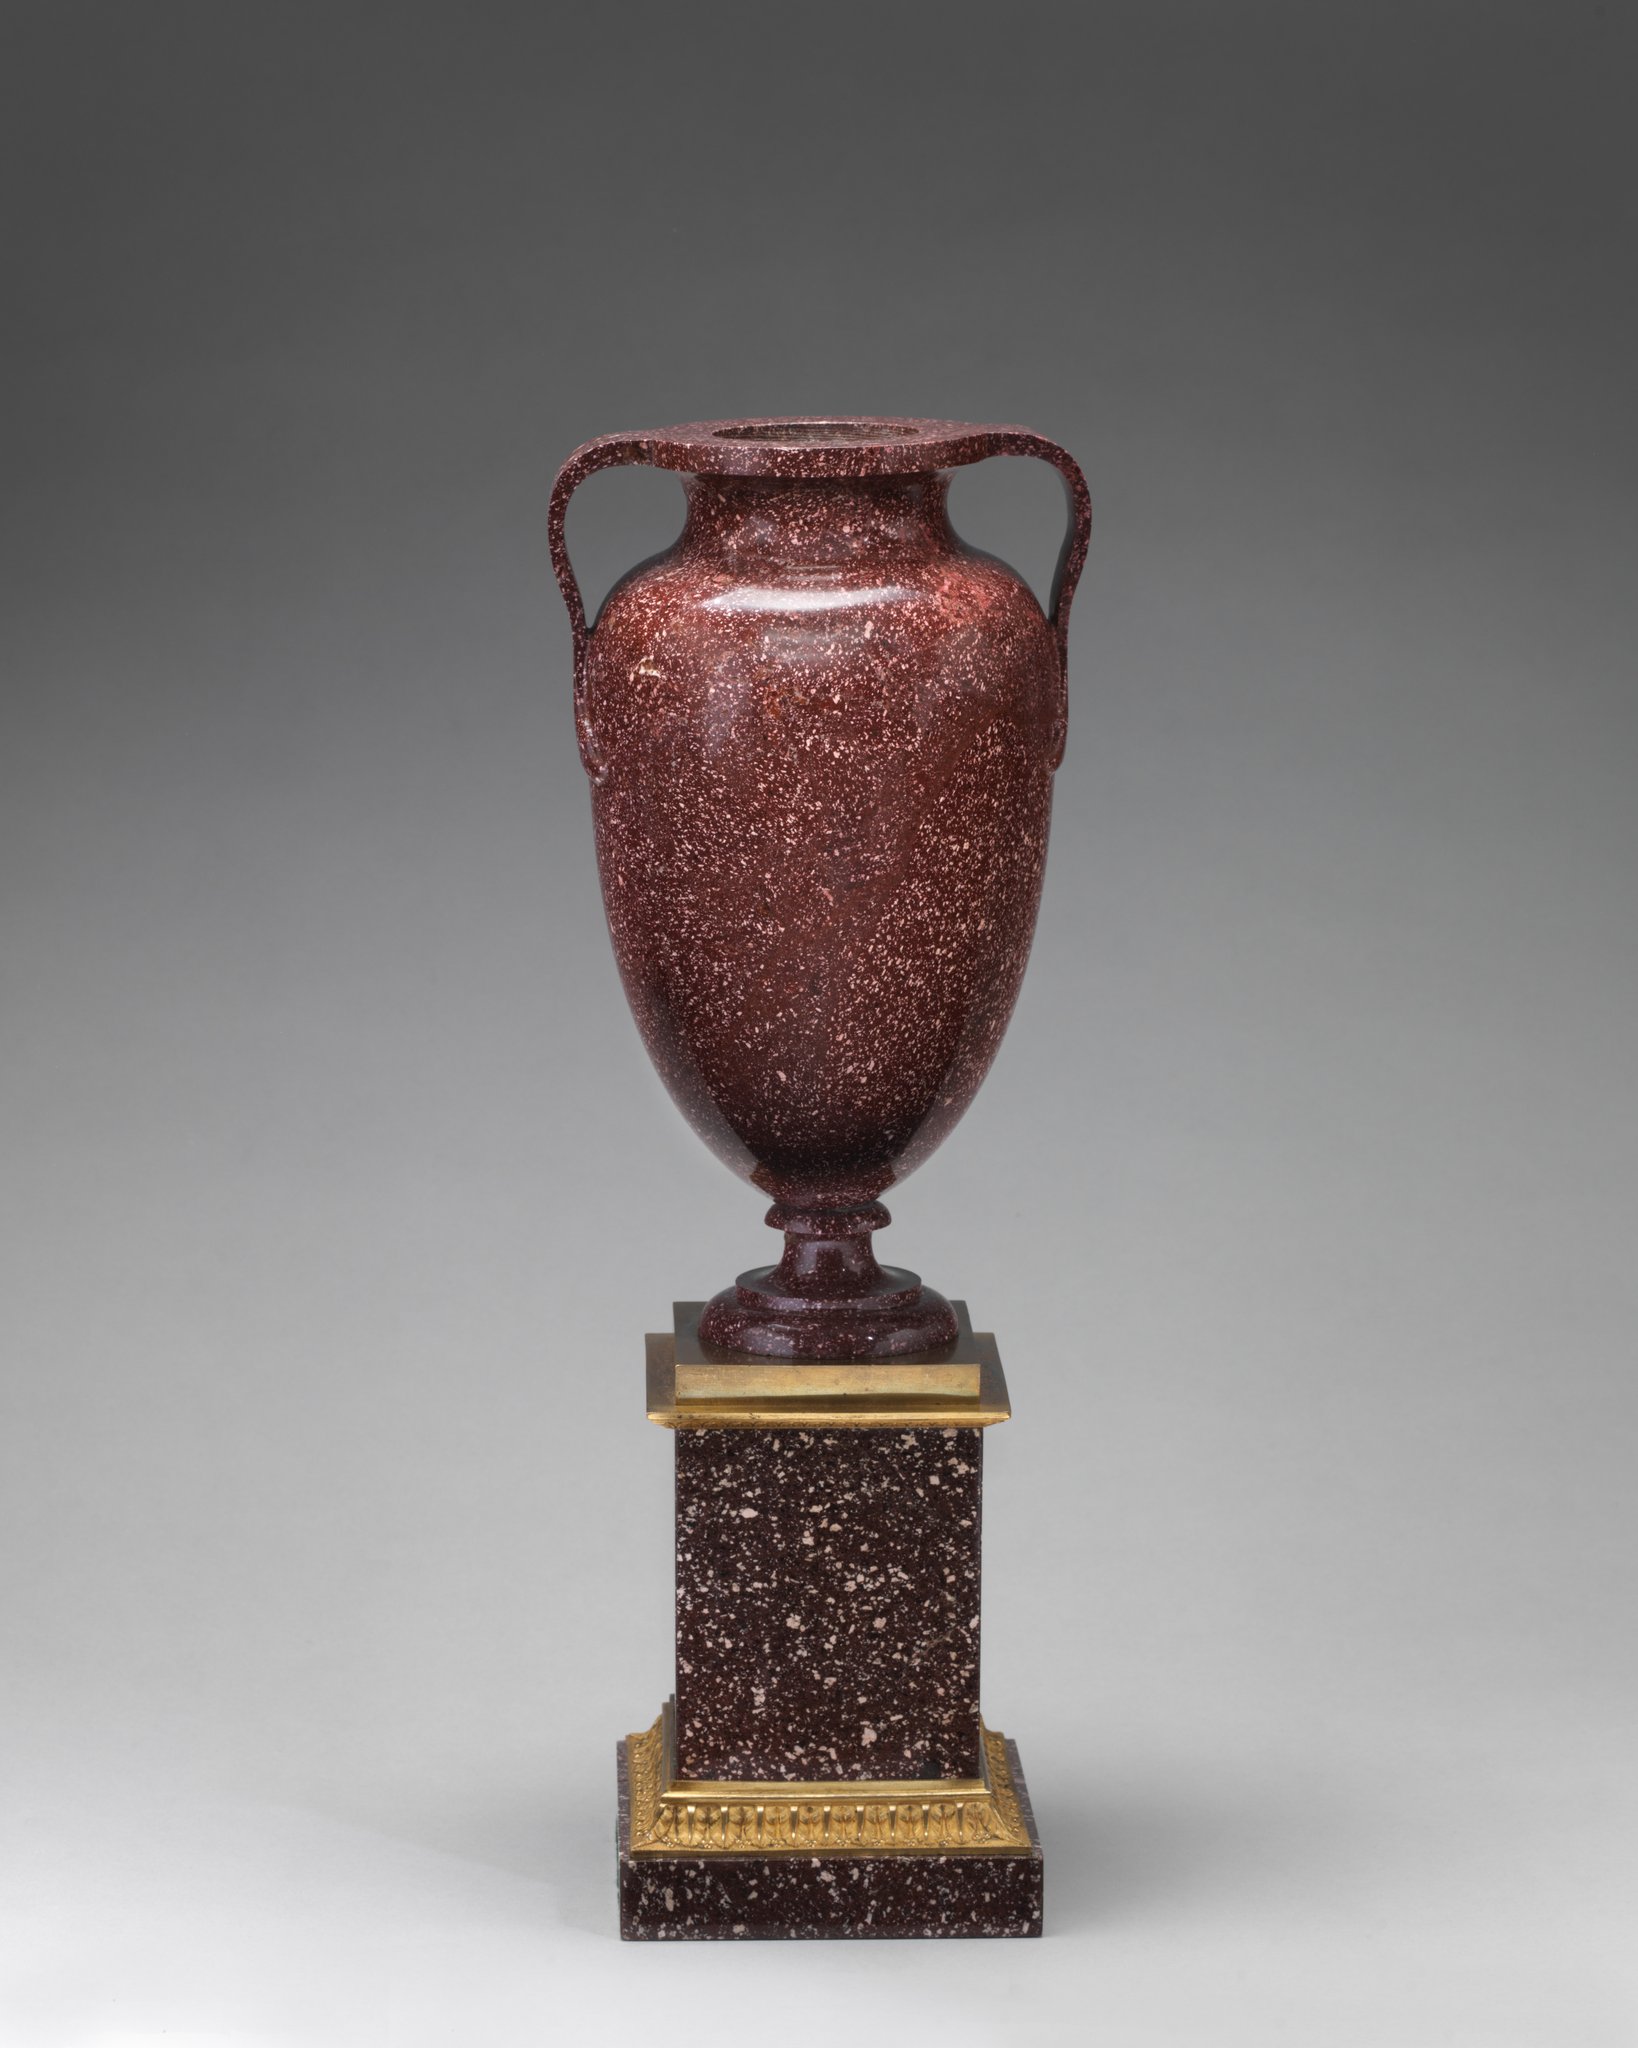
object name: urn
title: Urn on square base (one of a pair)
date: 1770-1780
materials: gilt bronze